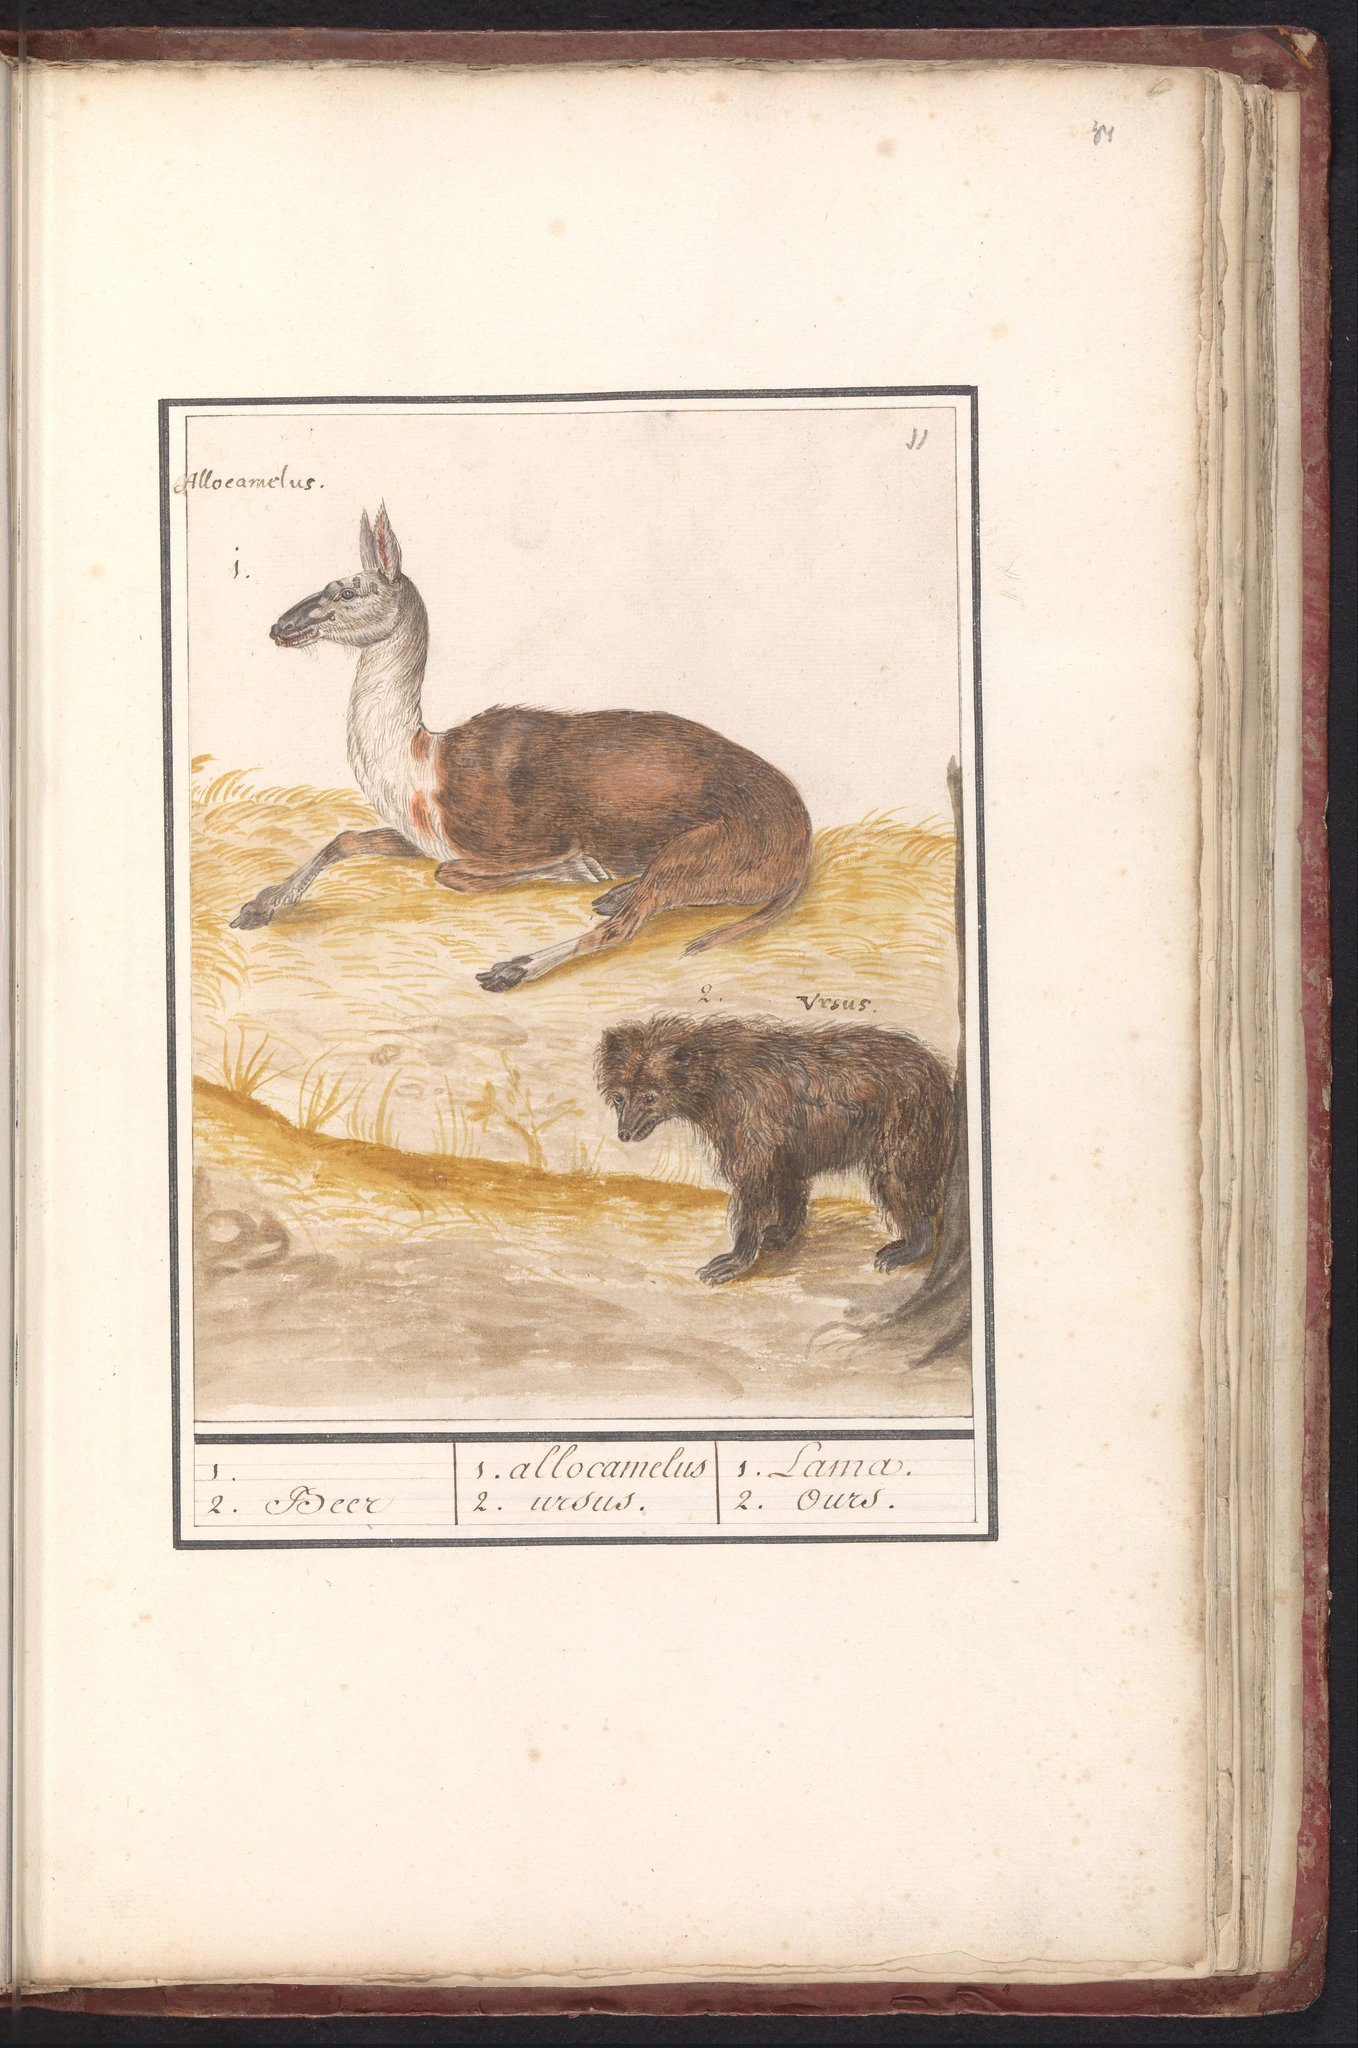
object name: drawing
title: Lama (Lama glama) en bruine beer (Ursus arctos arctos)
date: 1596-1610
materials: paint, ink, paper, watercolor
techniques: brush, pen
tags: hoofed animals: lama, beasts of prey, predatory animals: bear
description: Lama en Europese bruine beer. Genummerd rechtsboven: 11. Met de namen in het Latijn. Onderdeel van het tweede album met tekeningen van viervoeters. Tweede van twaalf albums met tekeningen van dieren, vogels en planten bekend rond 1600, gemaakt in opdracht van keizer Rudolf II. Met toelichting in Nederlands, Latijn en Frans.